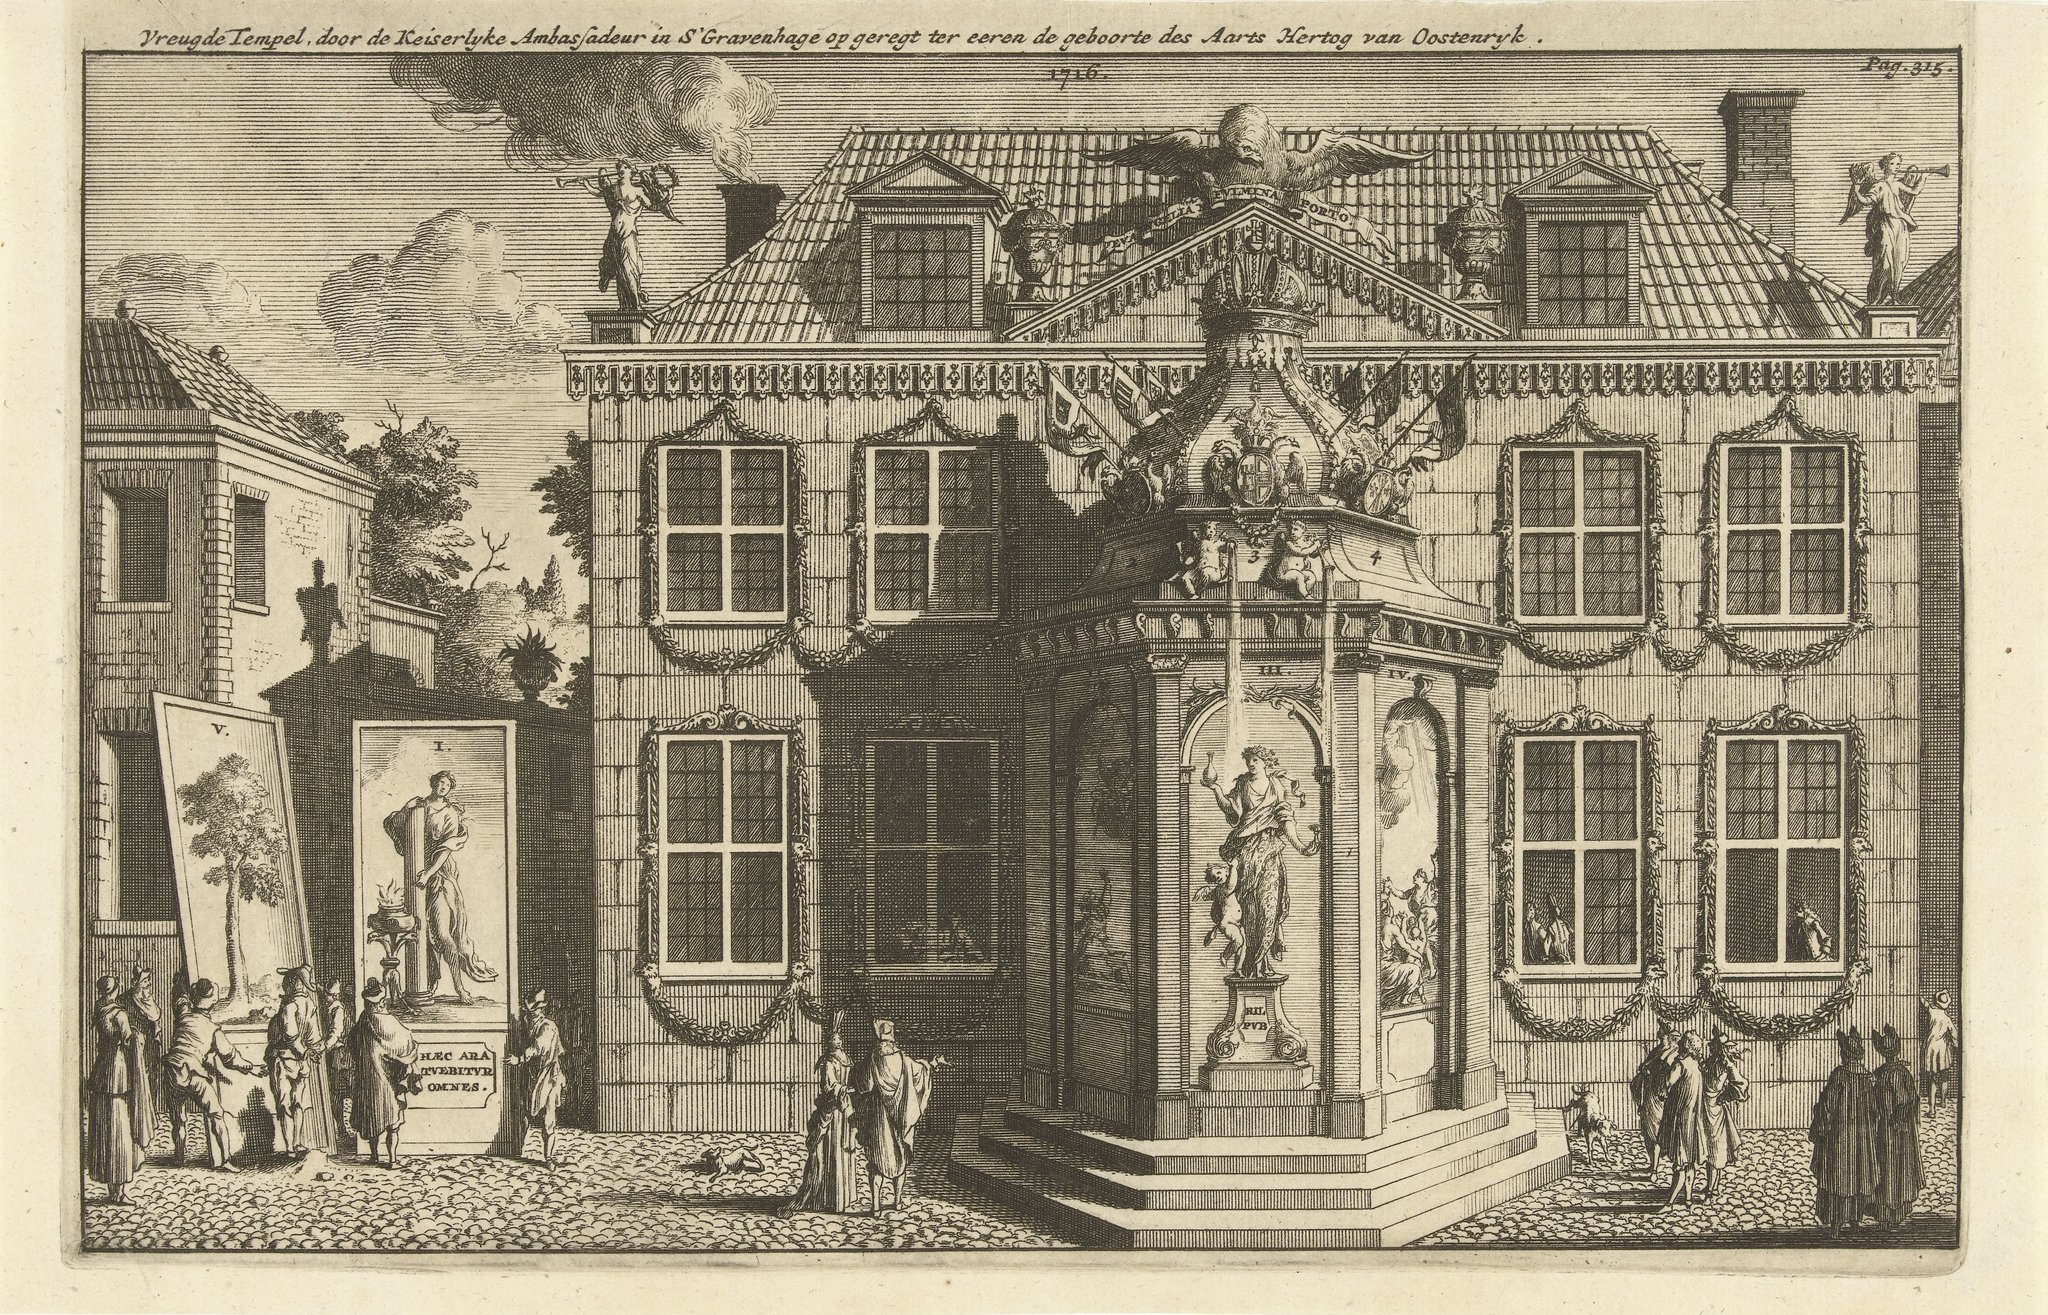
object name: print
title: Vreugde Tempel, door de Keiserlyke Ambassadeur in S'Gravenhage op geregt ter eeren de geboorte des Aarts Hertog van Oostenryk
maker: Anonymous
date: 1716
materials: paper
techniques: etching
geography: northern netherlands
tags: public festivities at birth of royal persons (+ festive decoration ~ festive activities), the hague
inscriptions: collector's mark: Lugt 2228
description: Tempel opgericht in juni 1716 voor het huis van de keizerlijke ambassadeur Arnold baron von Heems te Den Haag ter ere van de geboorte op 13 april 1716 van de jonge aartshertog Leopold Johan (de kroonprins overleed in hetzelfde jaar). Uitbouw versierd met allegorische figuren, wapens en vaandels. Links bekijken enkele voorbijgangers beschilderde panelen. Rechtsboven gemerkt: Pag. 315.